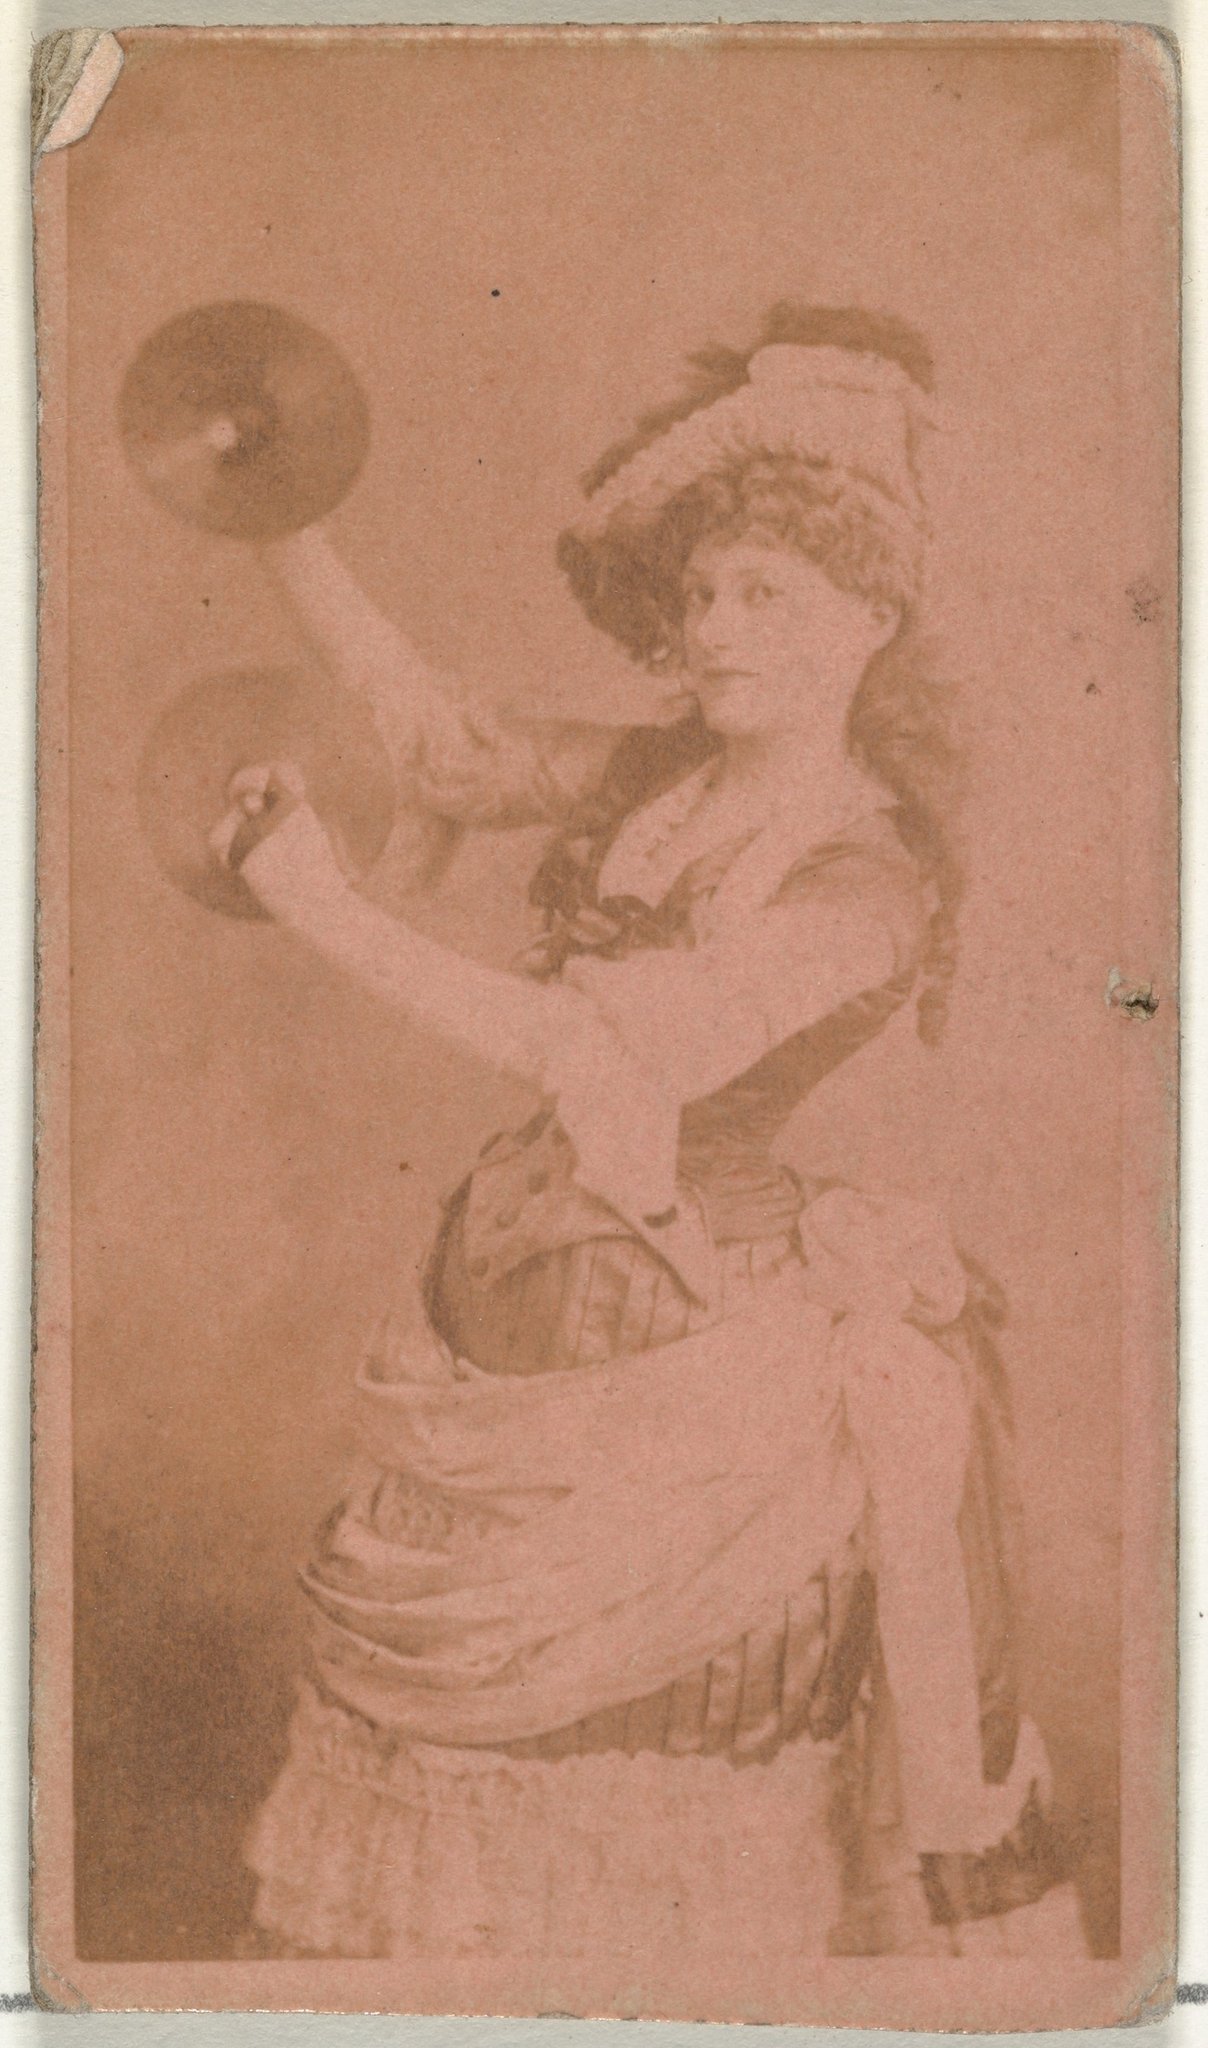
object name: photograph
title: [Actress playing two cymbals], from the Actors and Actresses series (N145-8) issued by Duke Sons & Co. to promote Duke Cigarettes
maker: w. duke, sons & co.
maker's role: publisher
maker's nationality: american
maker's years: 1870-1920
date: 1891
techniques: albumen silver print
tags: portraits,women,actresses